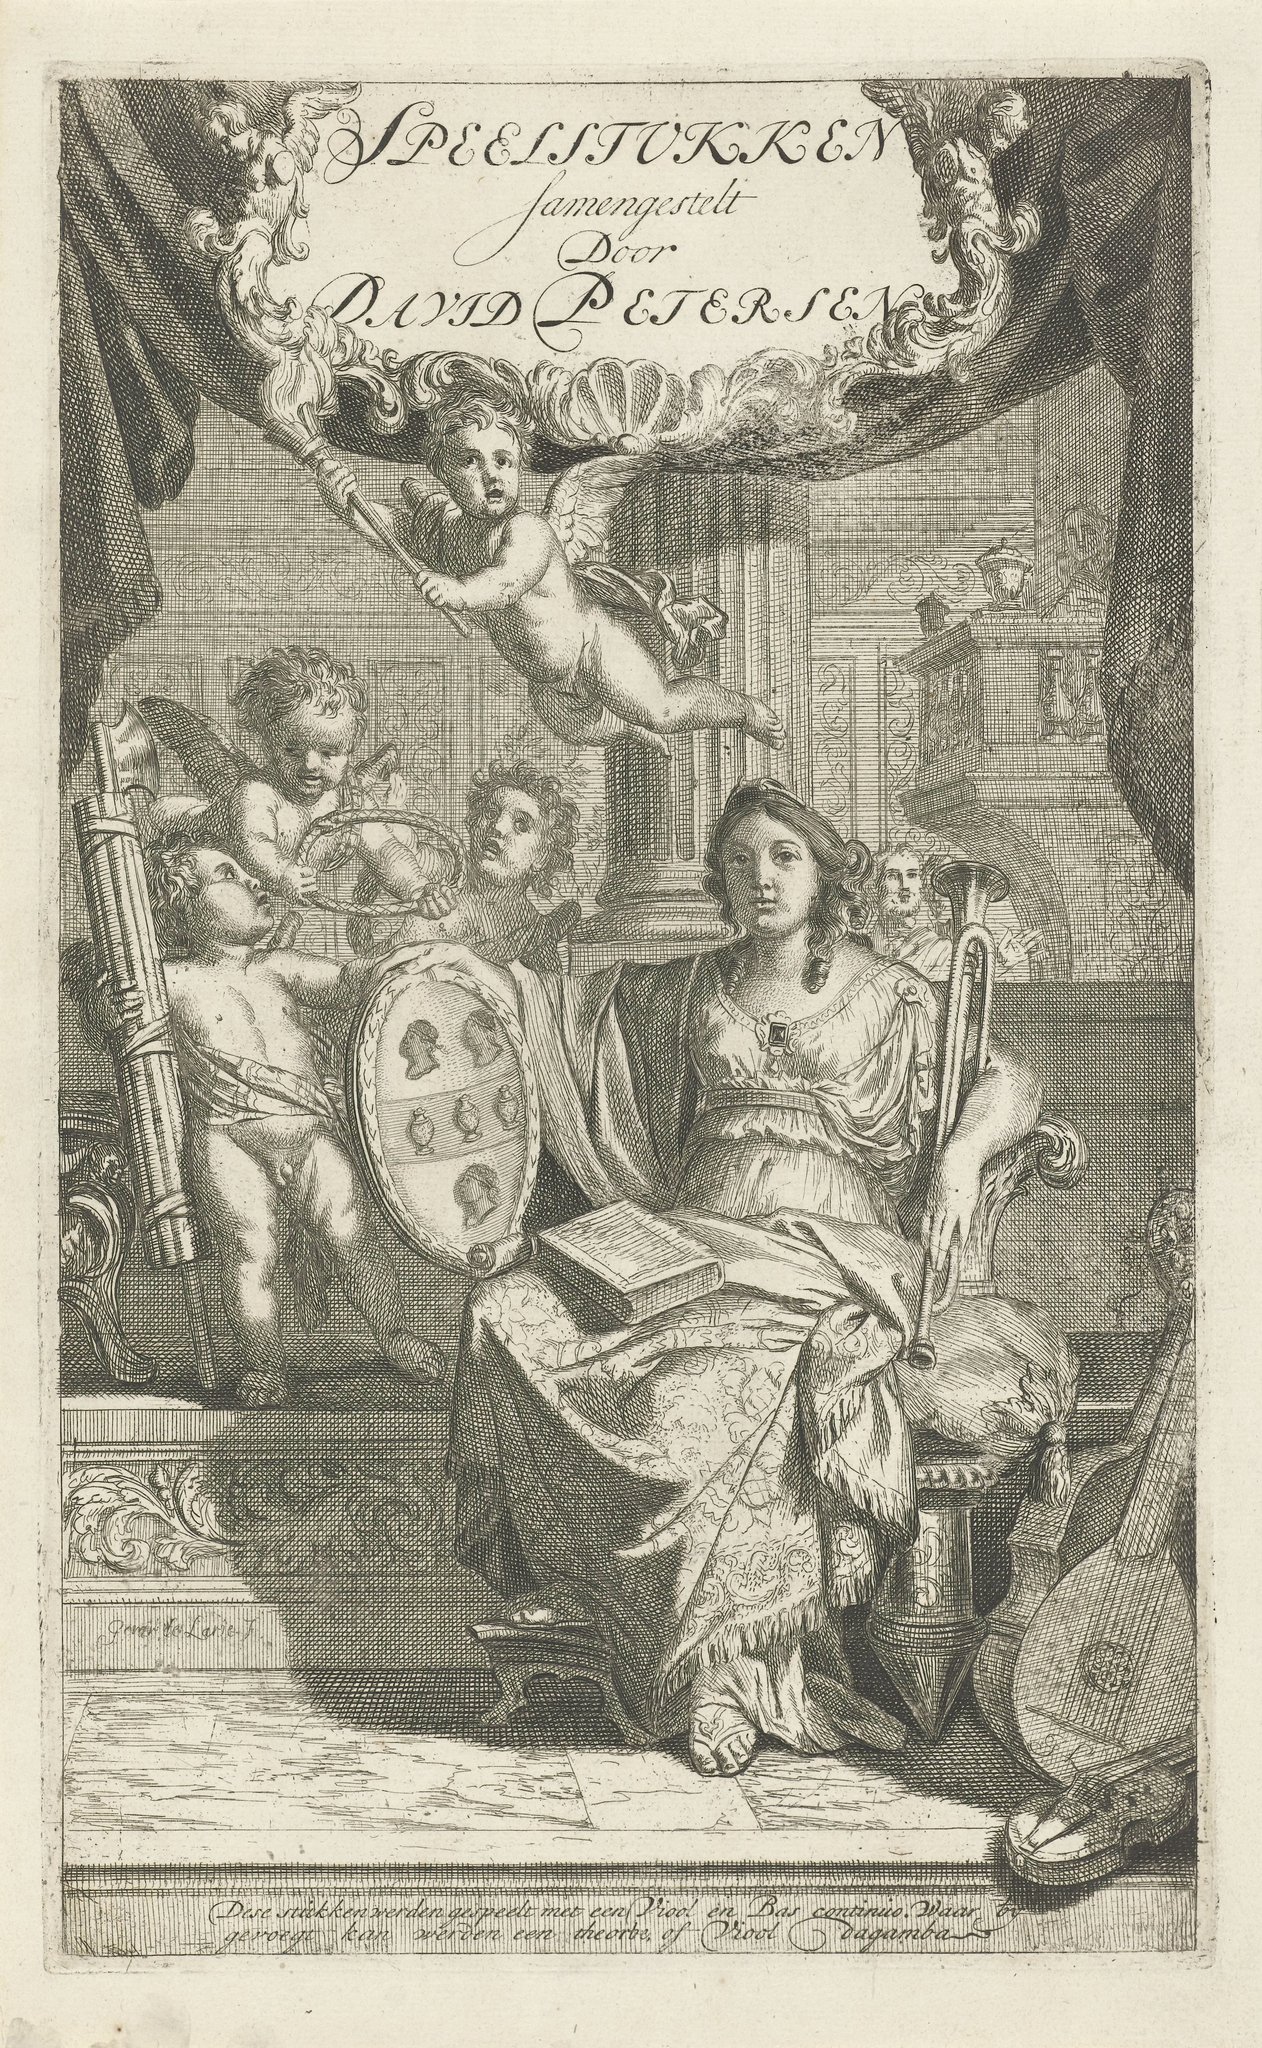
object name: print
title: Euterpe, muze van de muziek en lyriek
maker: gerard de lairesse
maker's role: draughtsman, painter, print maker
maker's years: 1641-1711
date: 1683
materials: paper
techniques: etching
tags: violin, fiddle, serpent ouroboros, lute, and special forms of lute, e.g.: theorbo, other string instruments (plucked), euterpe (one of the muses); 'euterpe' (ripa), cupids: 'amores', 'amoretti', 'putti', armorial bearing, heraldry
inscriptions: collector's mark: Lugt 240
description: Euterpe, muze van de muziek en lyriek, zit met een trompet en een cartouche met wapenschild in haar handen op een stoel. Op haar schoot ligt een dichtgeslagen boek, naast haar liggen een viool, theorbe en een viola da gamba. Achter Euterpe vliegt een putto met een brandende toorts, links houden putti een fasces (symbool van eendracht) en een slang die zich in eigen staart bijt vast (symbool van eeuwigheid) vast. Onder de voorstelling staat een tweeregelig onderschrift in het Nederlands.